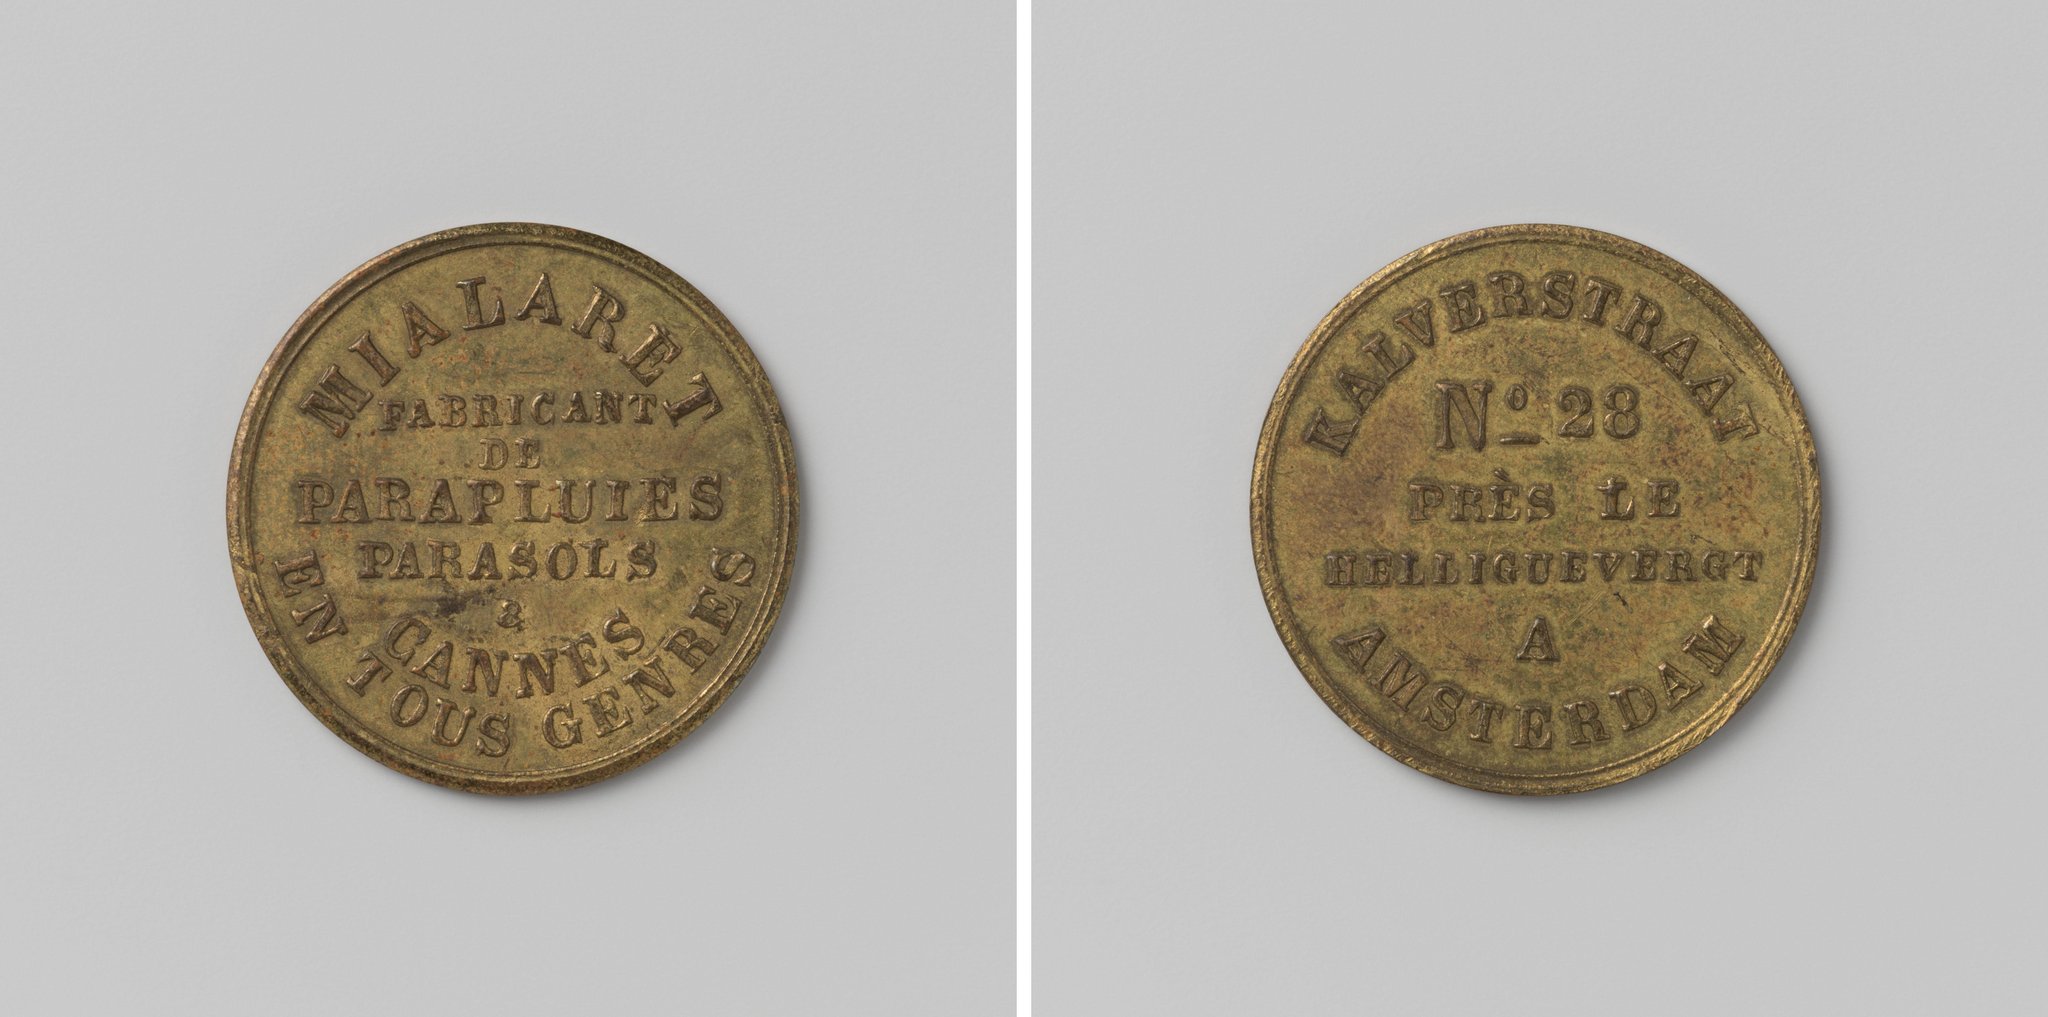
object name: adrespenning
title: Mialaret, fabrikant van paraplu's, parasols en wandelstokken aan de Kalverstraat no. 28 te Amsterdam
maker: Anonymous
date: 1840-1880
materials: brass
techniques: striking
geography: amsterdam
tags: kalverstraat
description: Messing penning. Voorzijde: opschrift binnen omschrift. Keerzijde: opschrift binnen omschrift